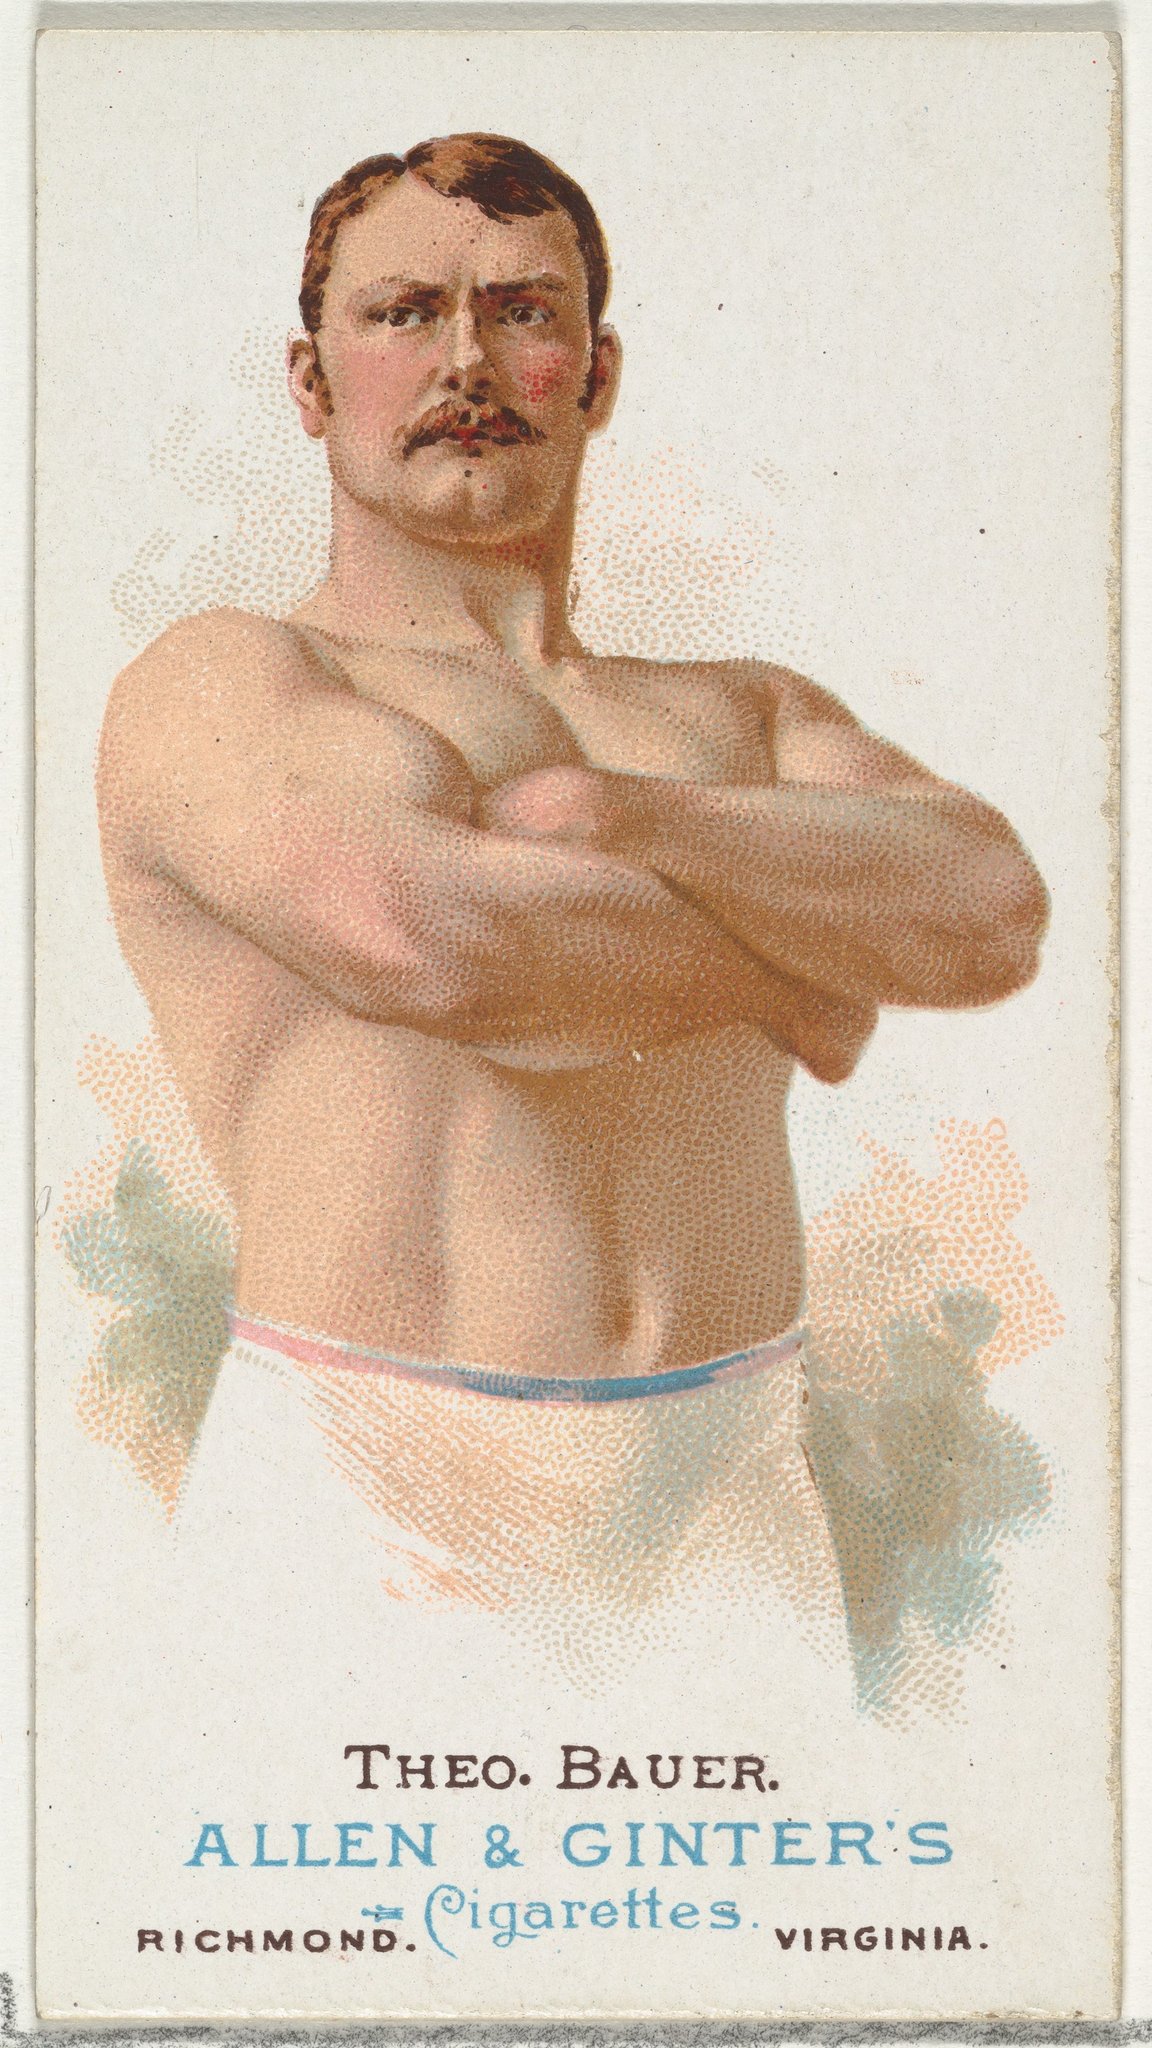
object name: print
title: Theodore Bauer, Wrestler, from World's Champions, Series 1 (N28) for Allen & Ginter Cigarettes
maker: allen & ginter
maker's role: publisher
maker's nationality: american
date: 1887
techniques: color lithograph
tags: men,portraits,athletes